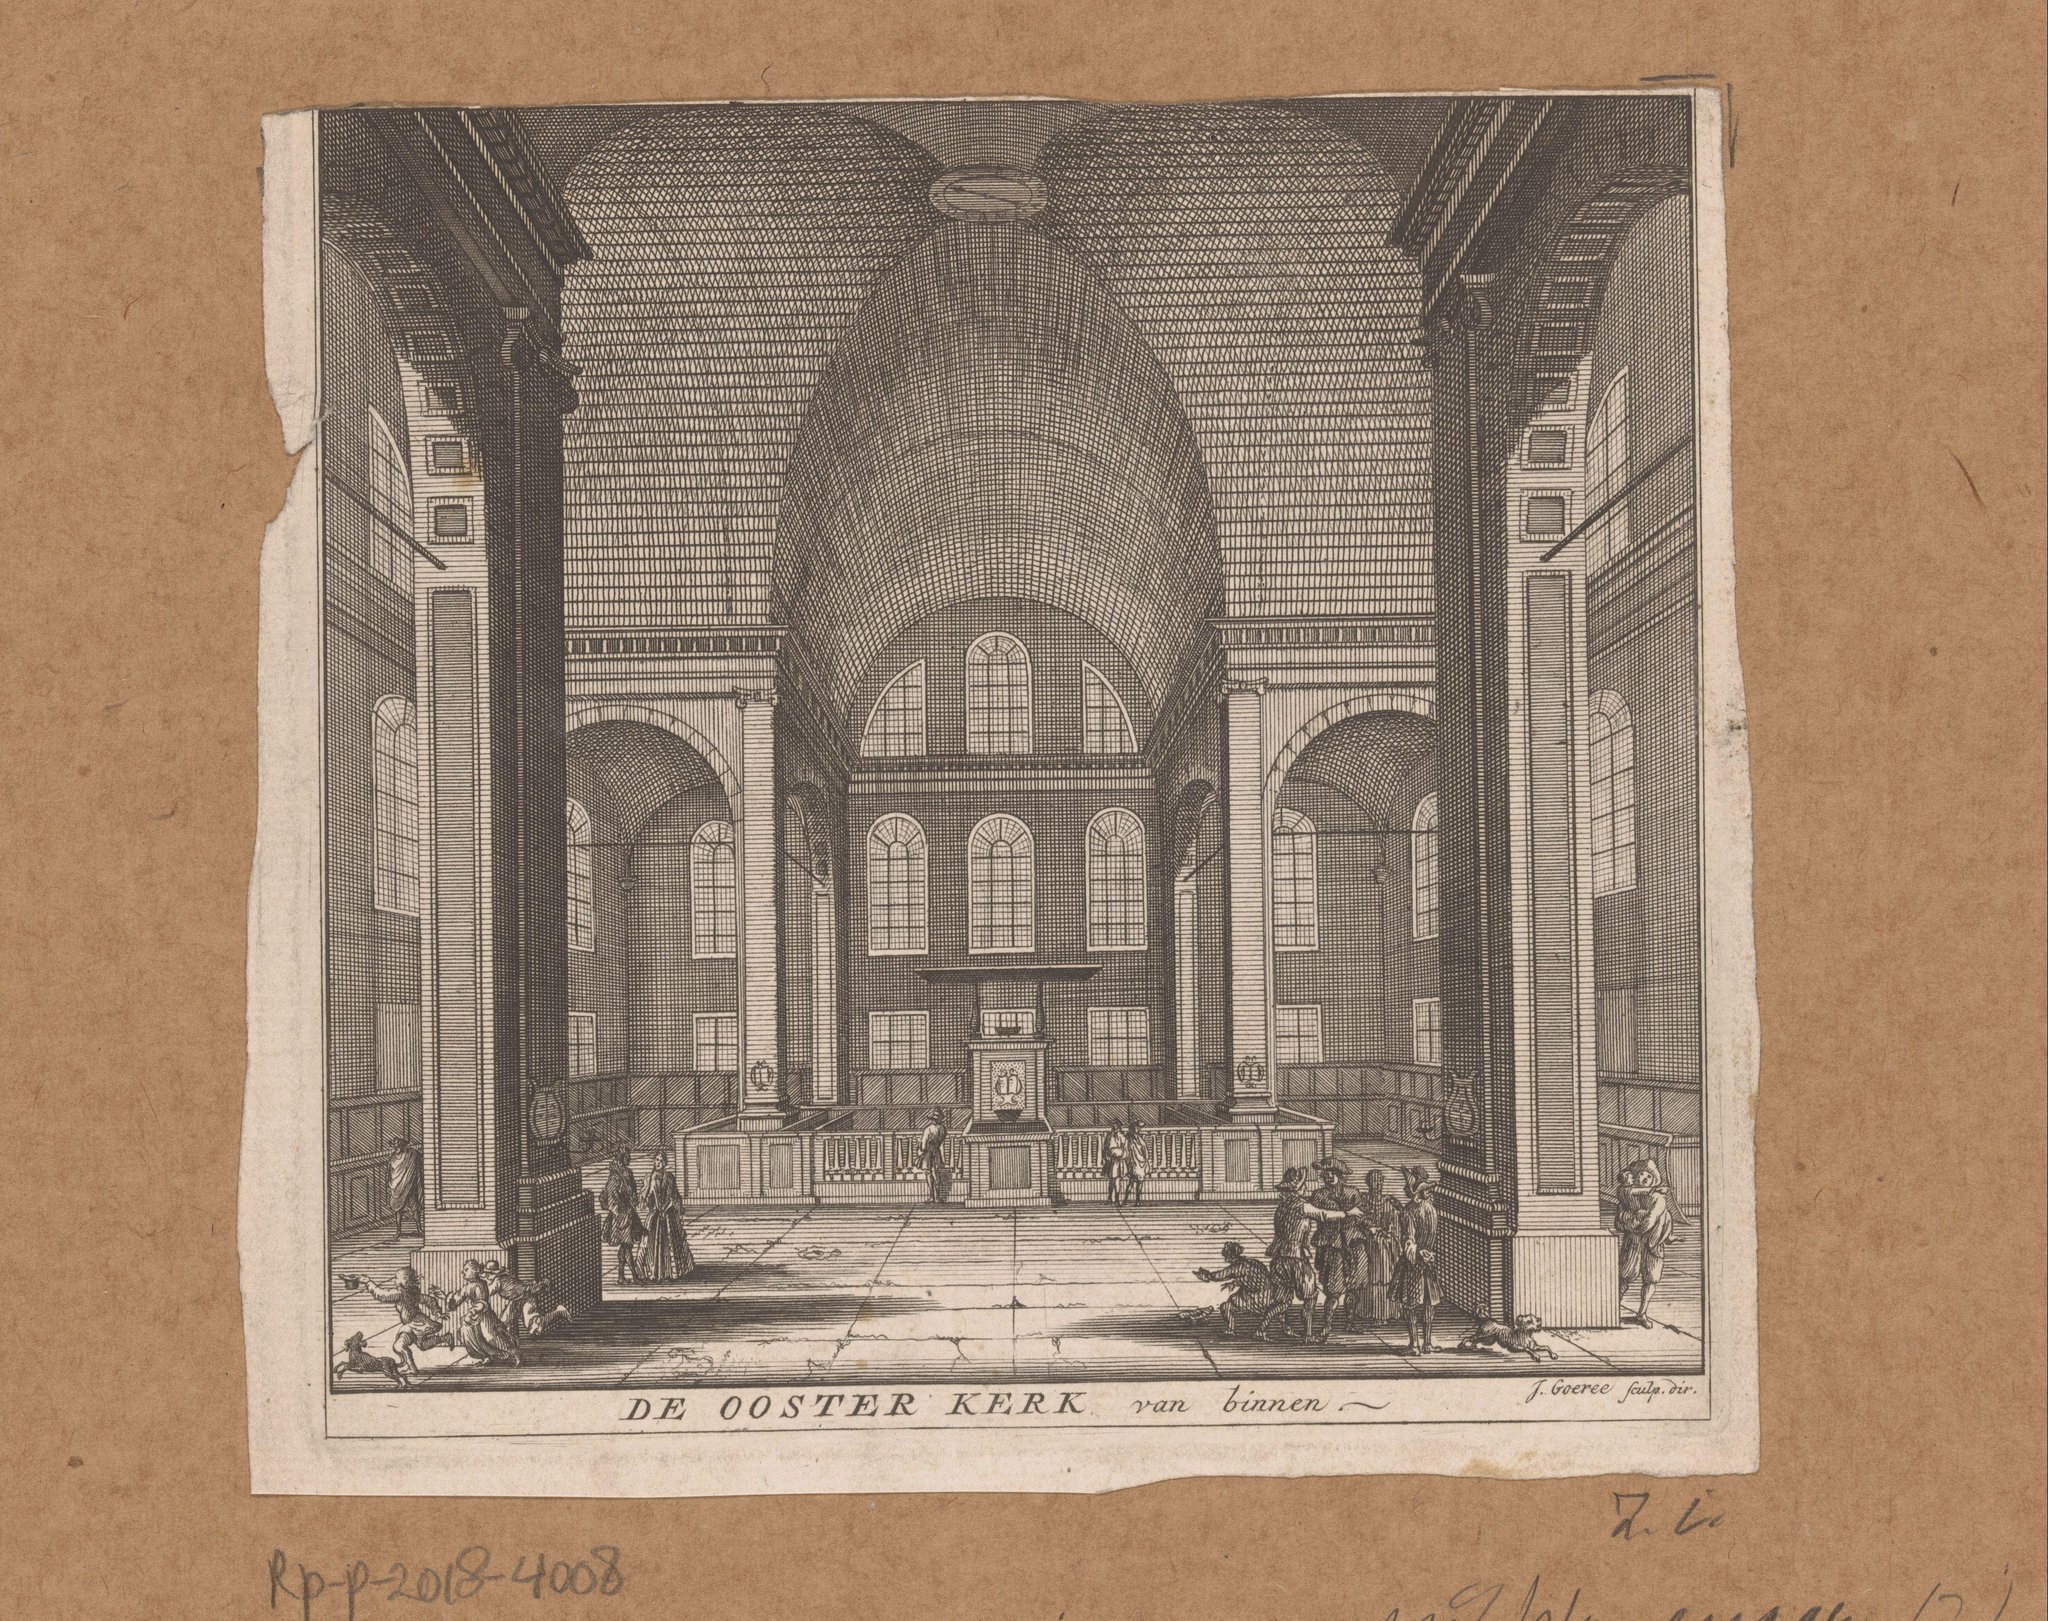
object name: print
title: Gezicht op het interieur van de Oosterkerk te Amsterdam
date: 1680-1731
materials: paper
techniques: etching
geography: amsterdam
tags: interior of church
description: Na Goeree's overlijden in 1731 is de prent in ieder geval nog gebruikt in: Wagenaar, Jan. Amsterdam in zijne opkomst, aanwas, geschiedenissen (...). Amsterdam: Isaak Tirion, 1765, dl. 2.